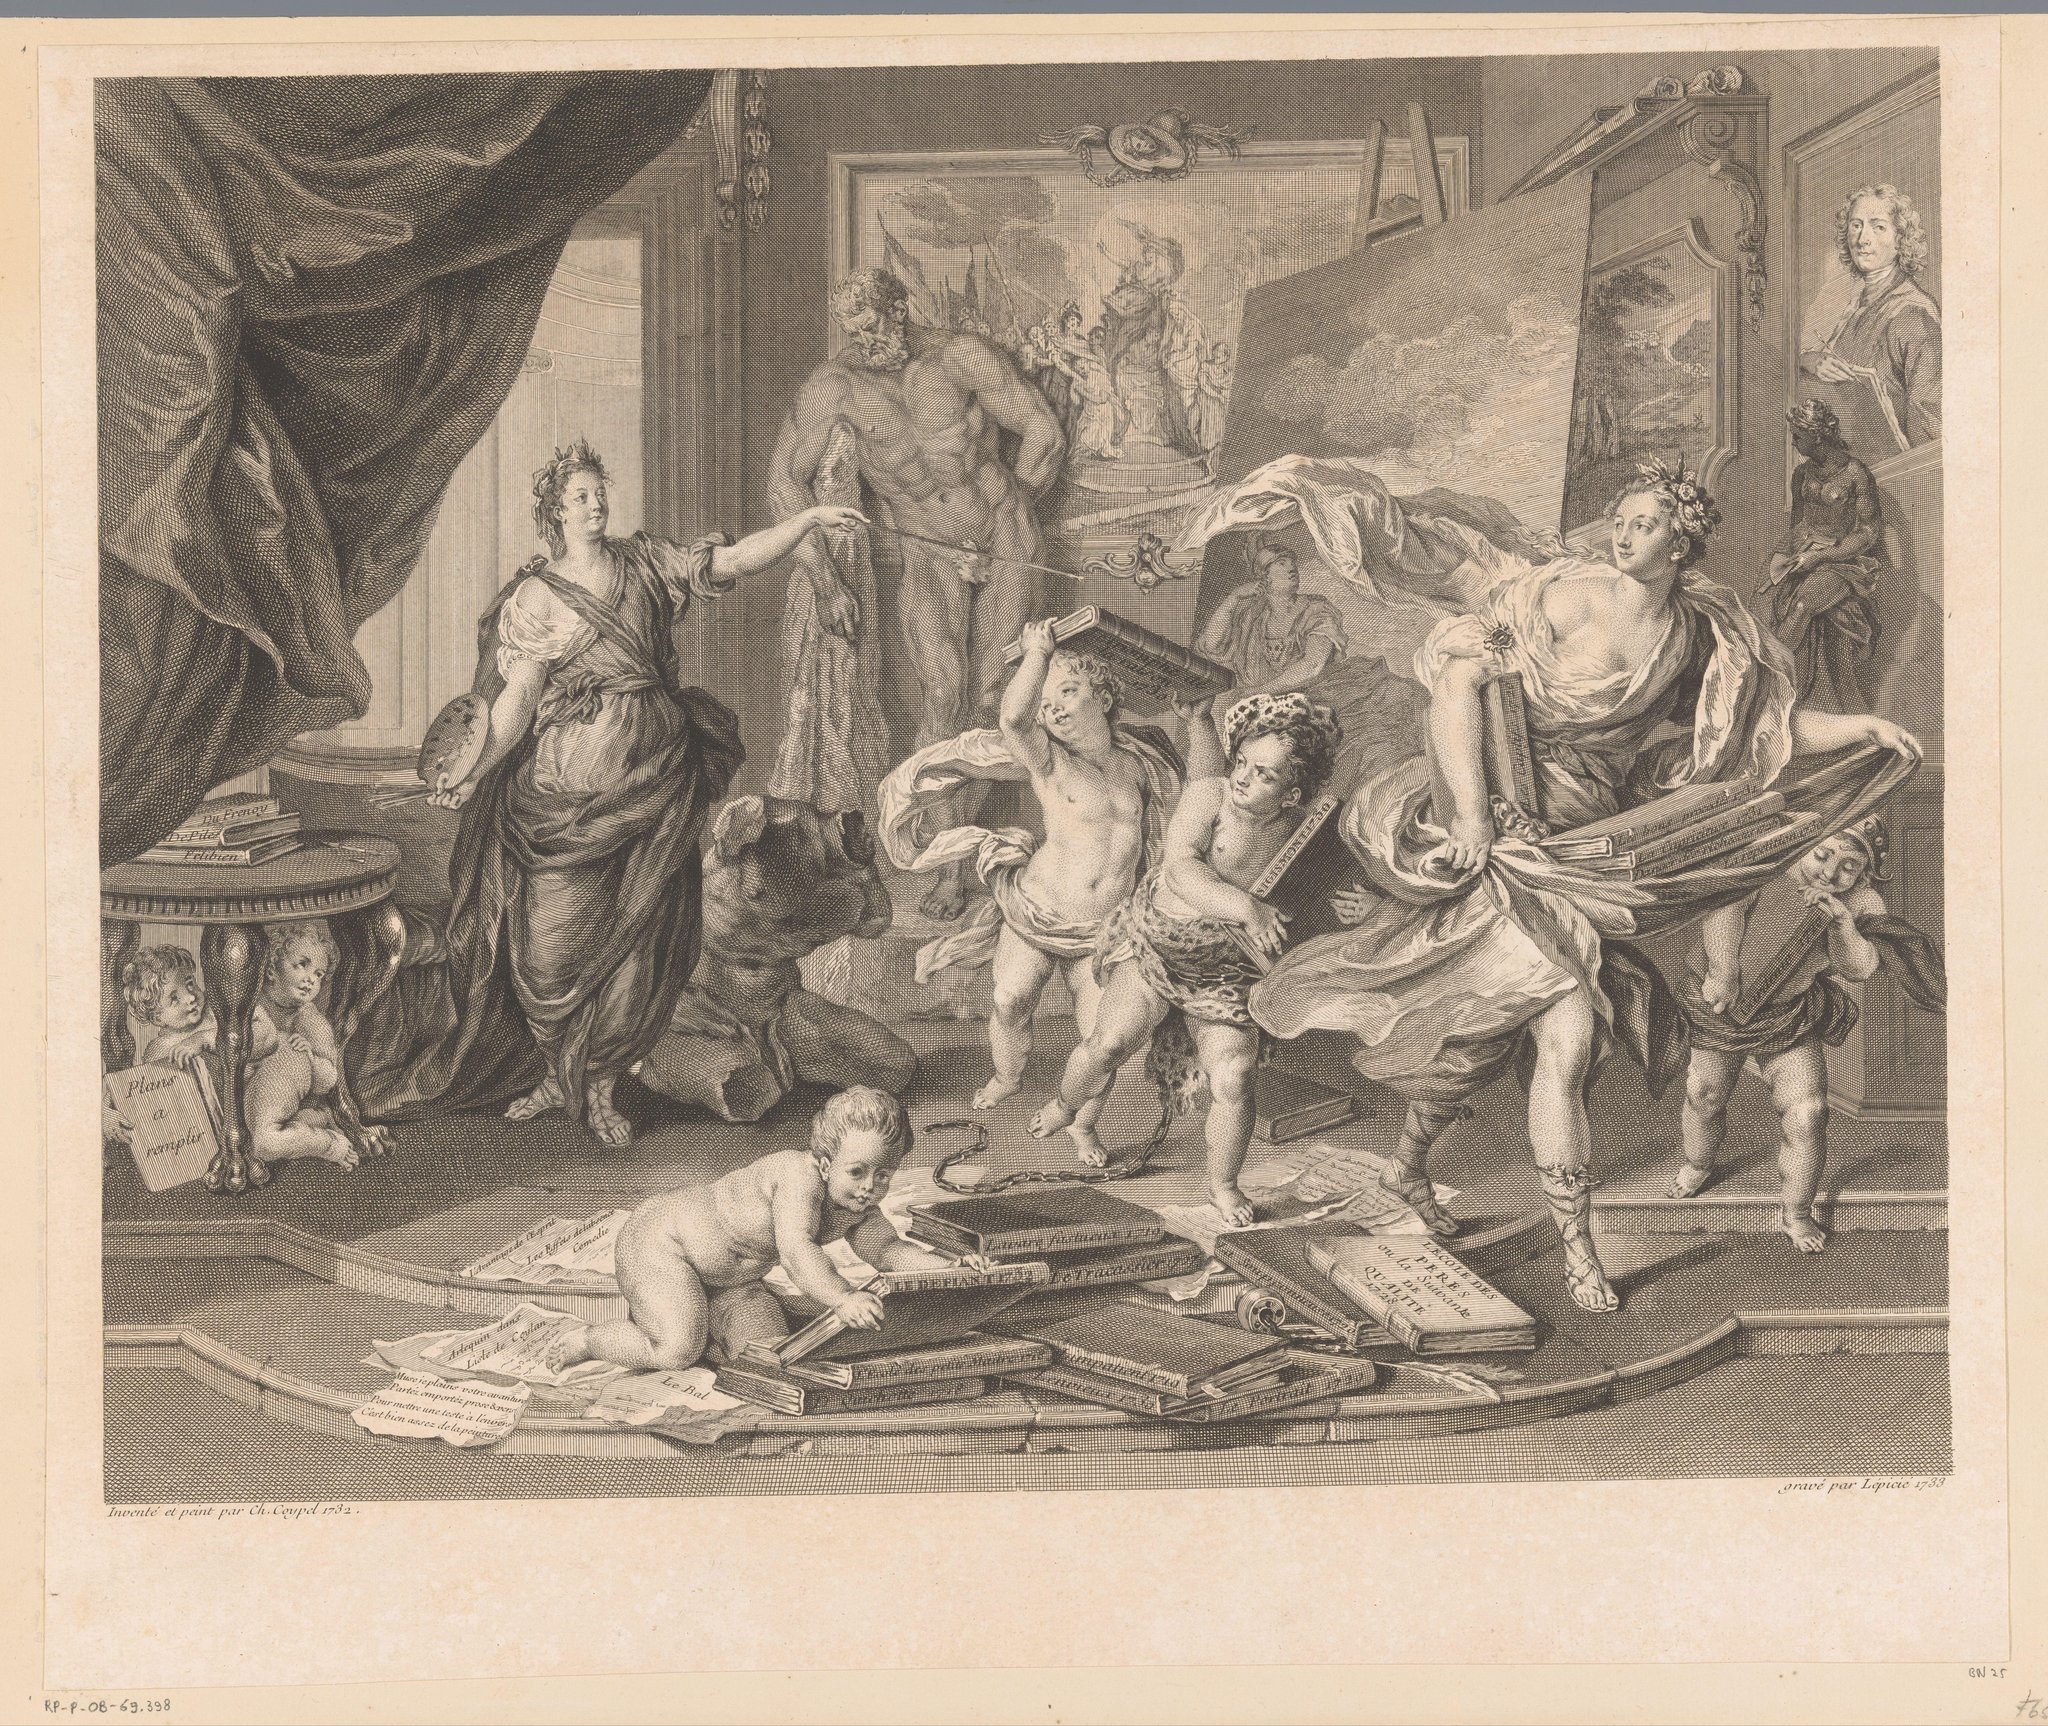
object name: print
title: Thalia verjaagd door de Schilderkunst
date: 1733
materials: paper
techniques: engraving, etching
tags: 'comedia', 'comedia vecchia' (ripa), 'pictura', symbolic representations, allegories and emblems ~ painting; 'pittura' (ripa), piece of sculpture, reproduction of a piece of sculpture, thalia (one of the muses); 'talia' (ripa)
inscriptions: collector's mark: Lugt 240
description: De muze Thalia, een stapel boeken dragend, wordt weggejaagd door de Schilderkunst. Deze heeft de gedaante van een vrouw met palet en penselen in de ene, een schilderstok in de andere hand. Naast de Schilderkunst een gebeeldhouwde tors. De Hercules Farnese staat voor een schilderij. Rechts aan de muur het portret van een schilder. De vloer ligt bezaaid met vroeg 18de-eeuwse uitgaven van toneelstukken.